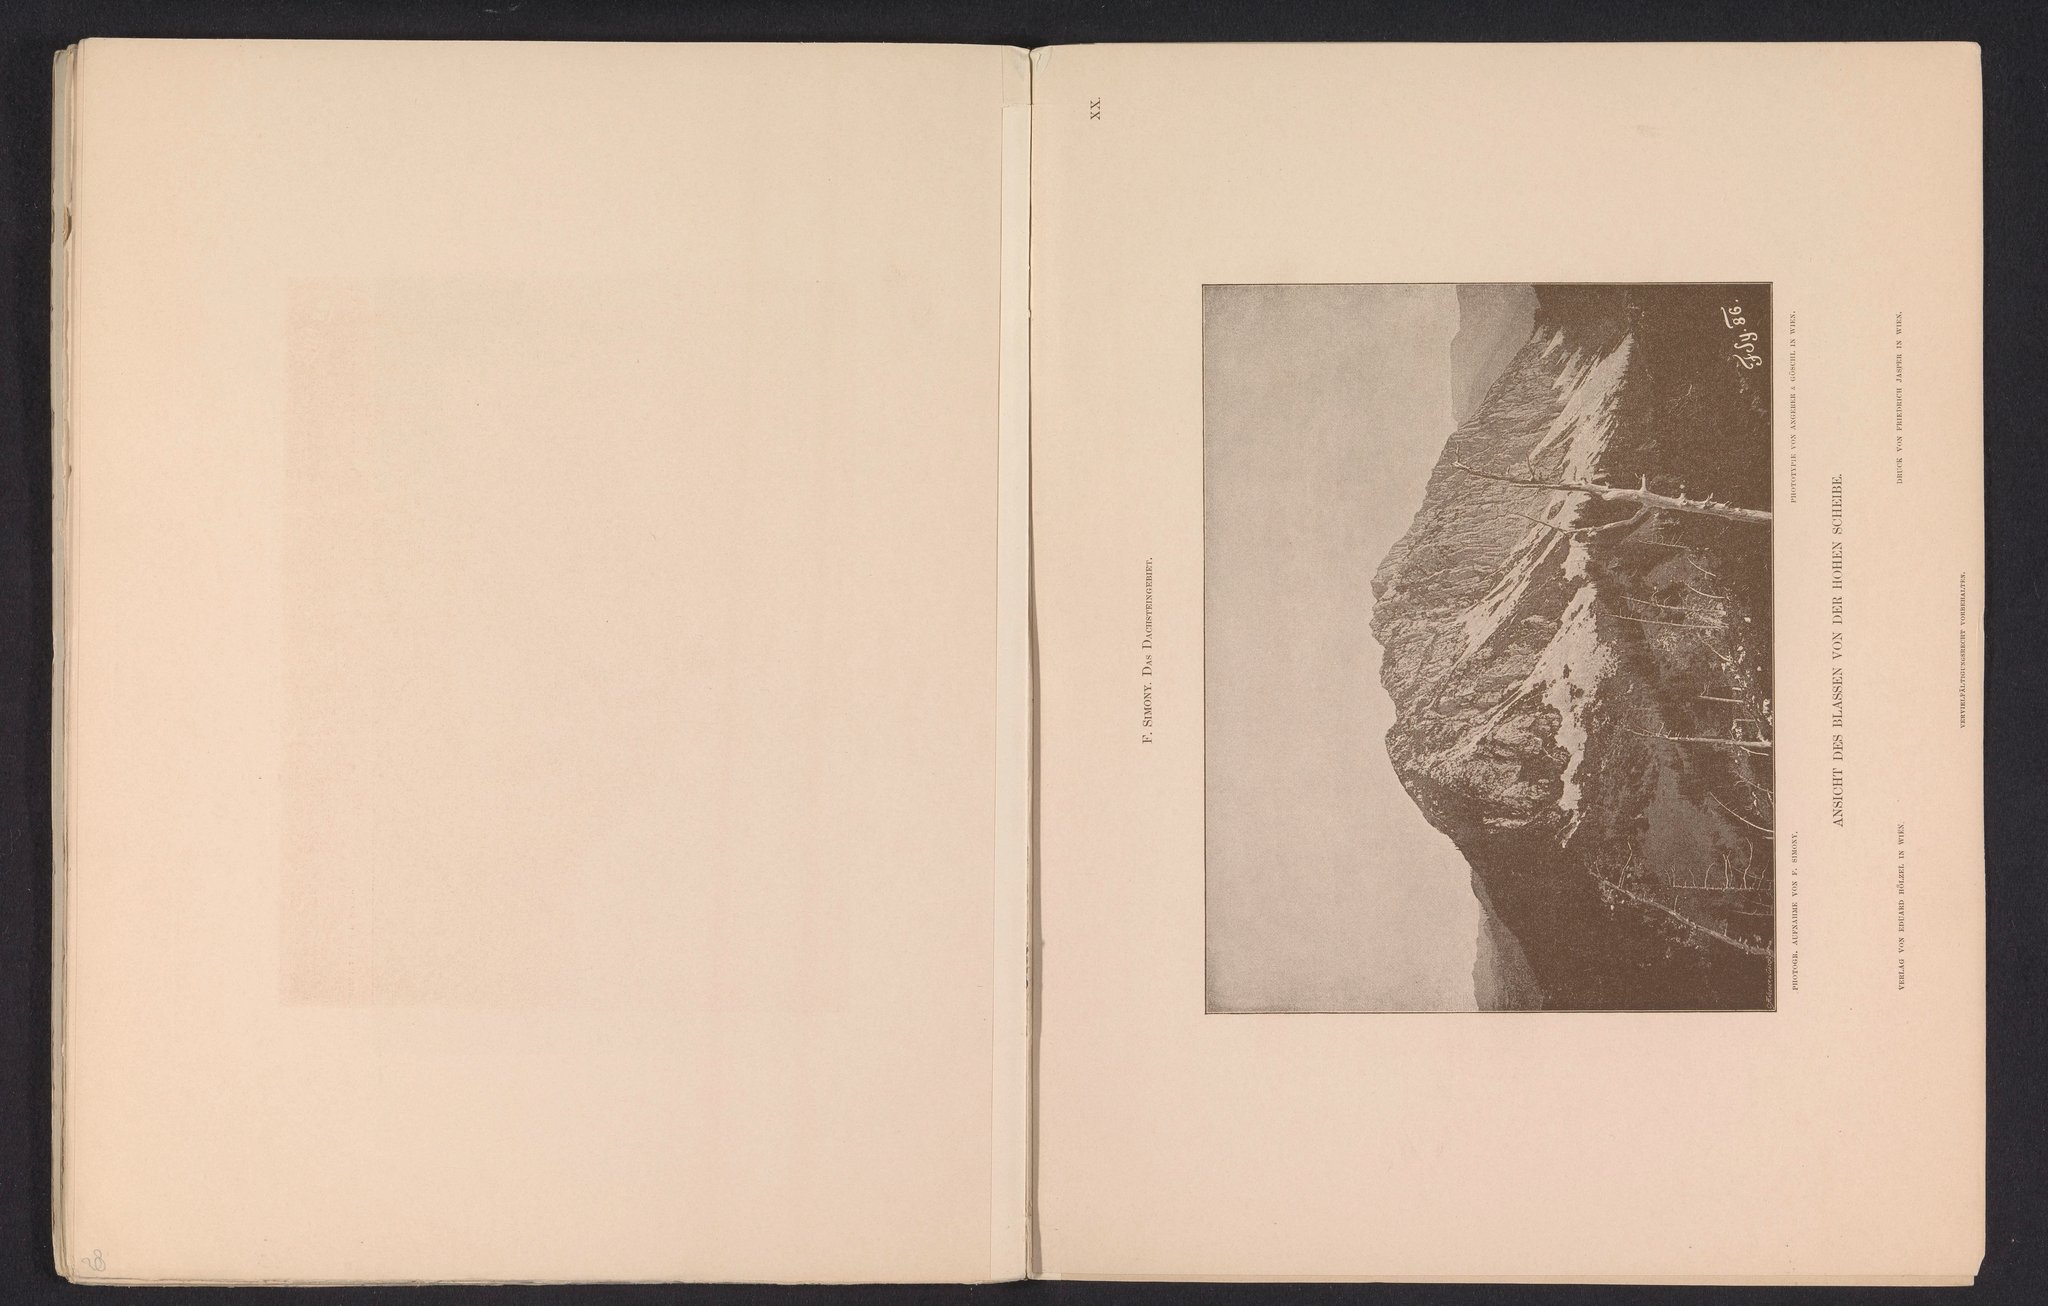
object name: photomechanical print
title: Ansicht des Blassen von der Hohen Scheibe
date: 1886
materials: paper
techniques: autotype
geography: vienna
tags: mountain-top, peak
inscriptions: number: ‘XX.’